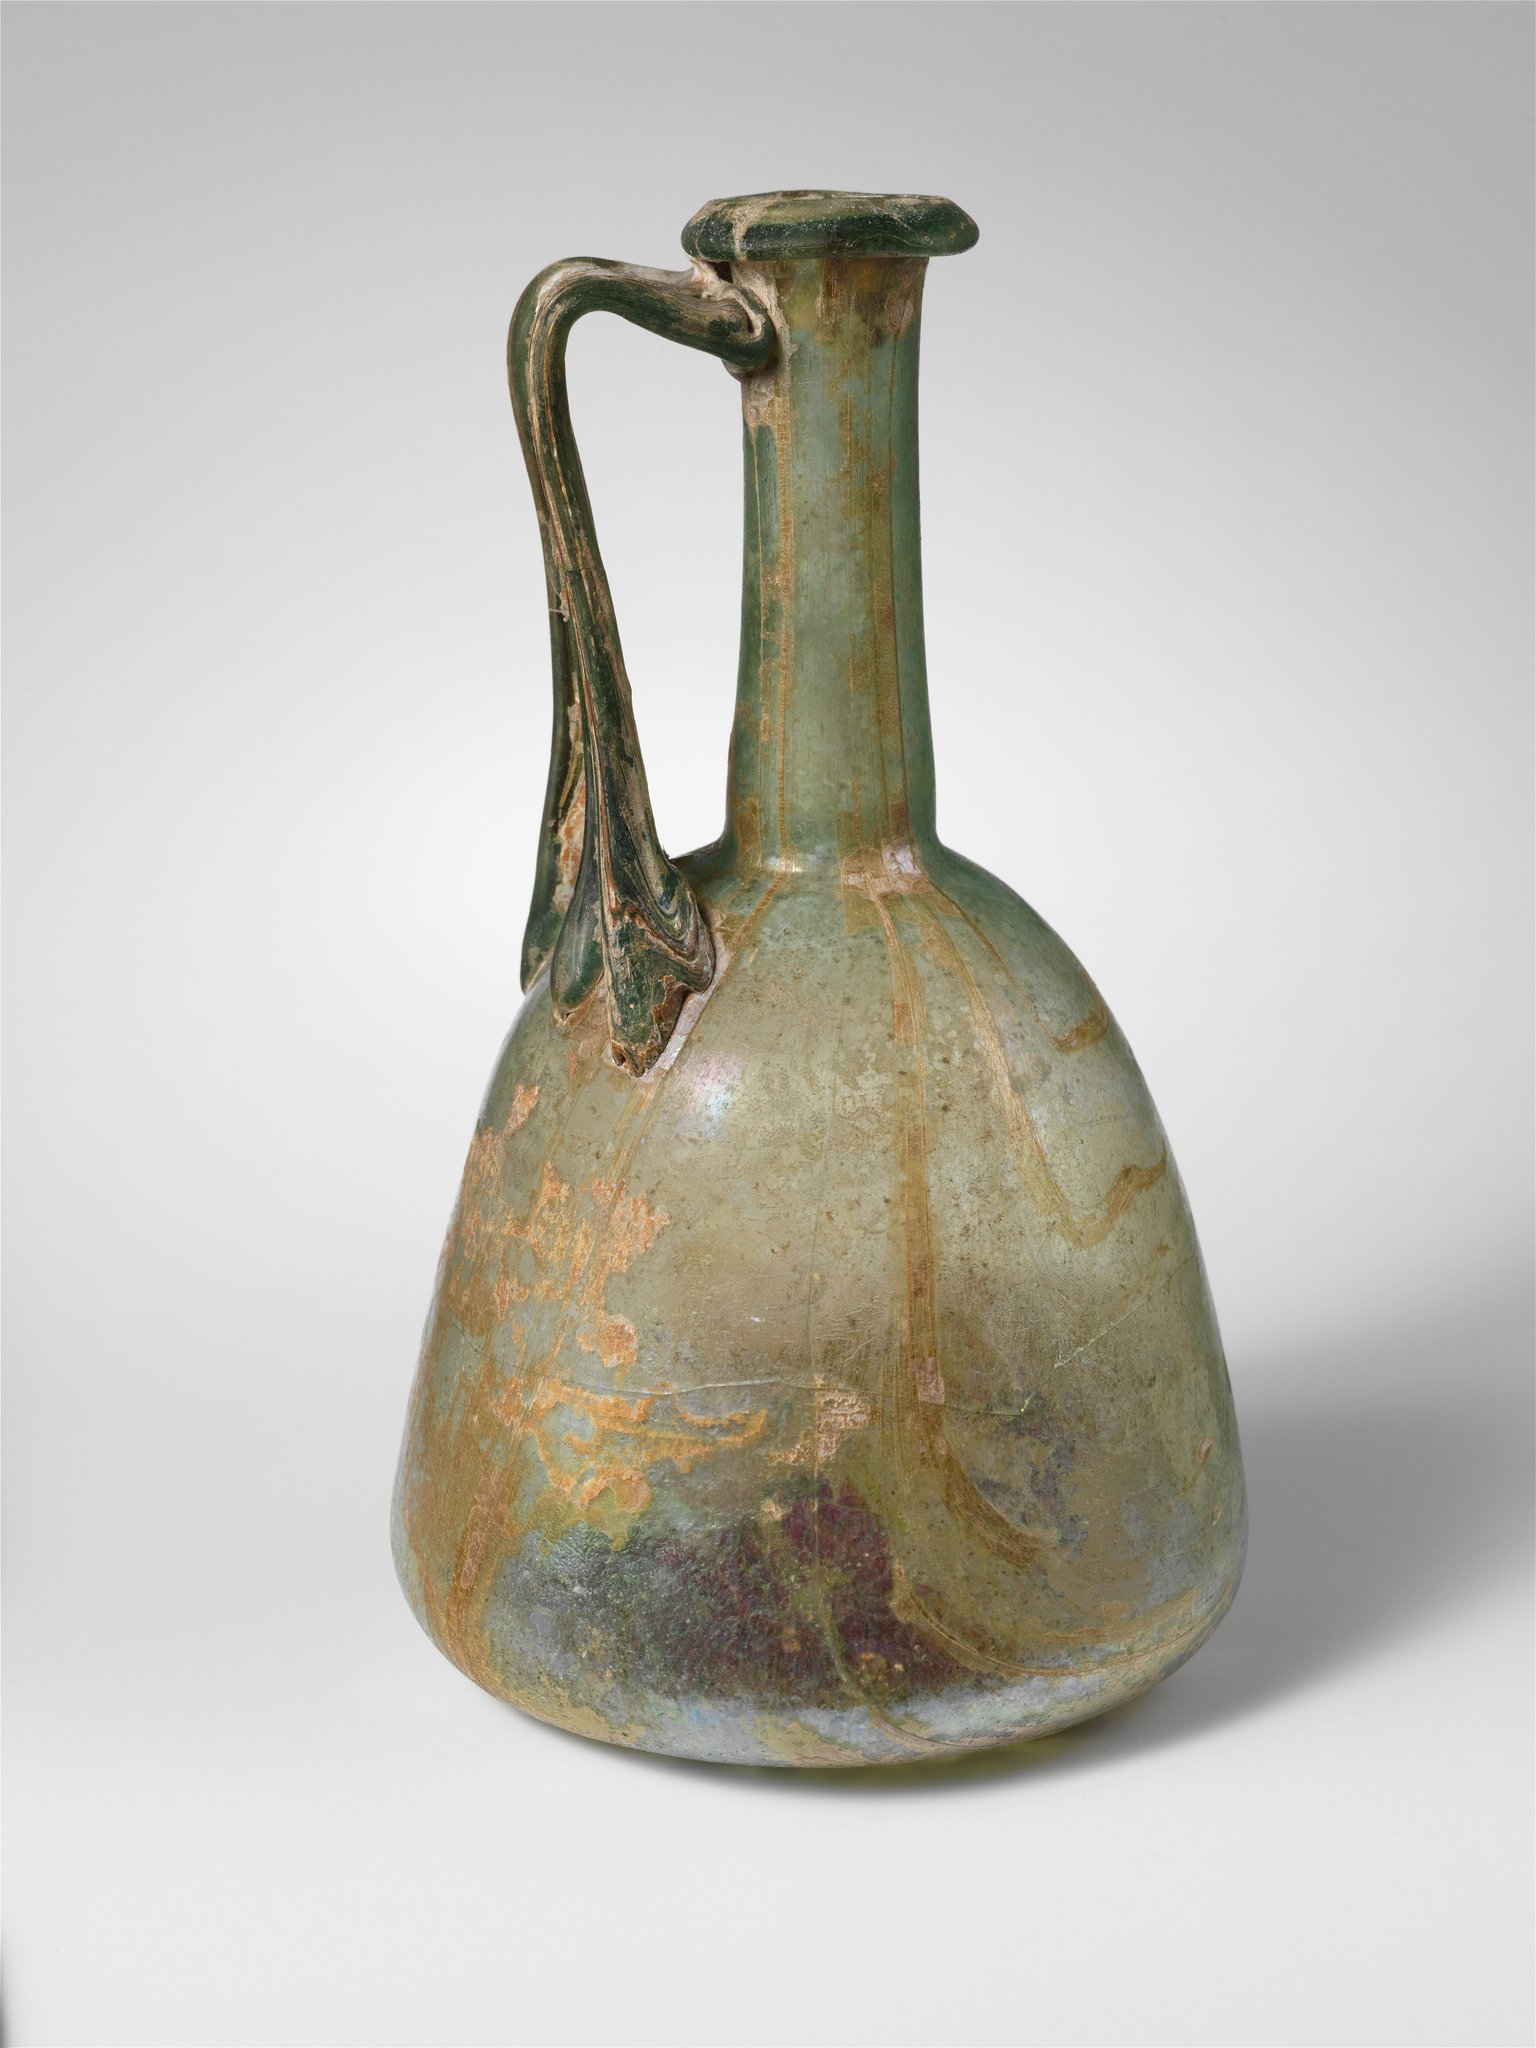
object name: jug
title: Glass jug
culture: roman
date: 1-200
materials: glass